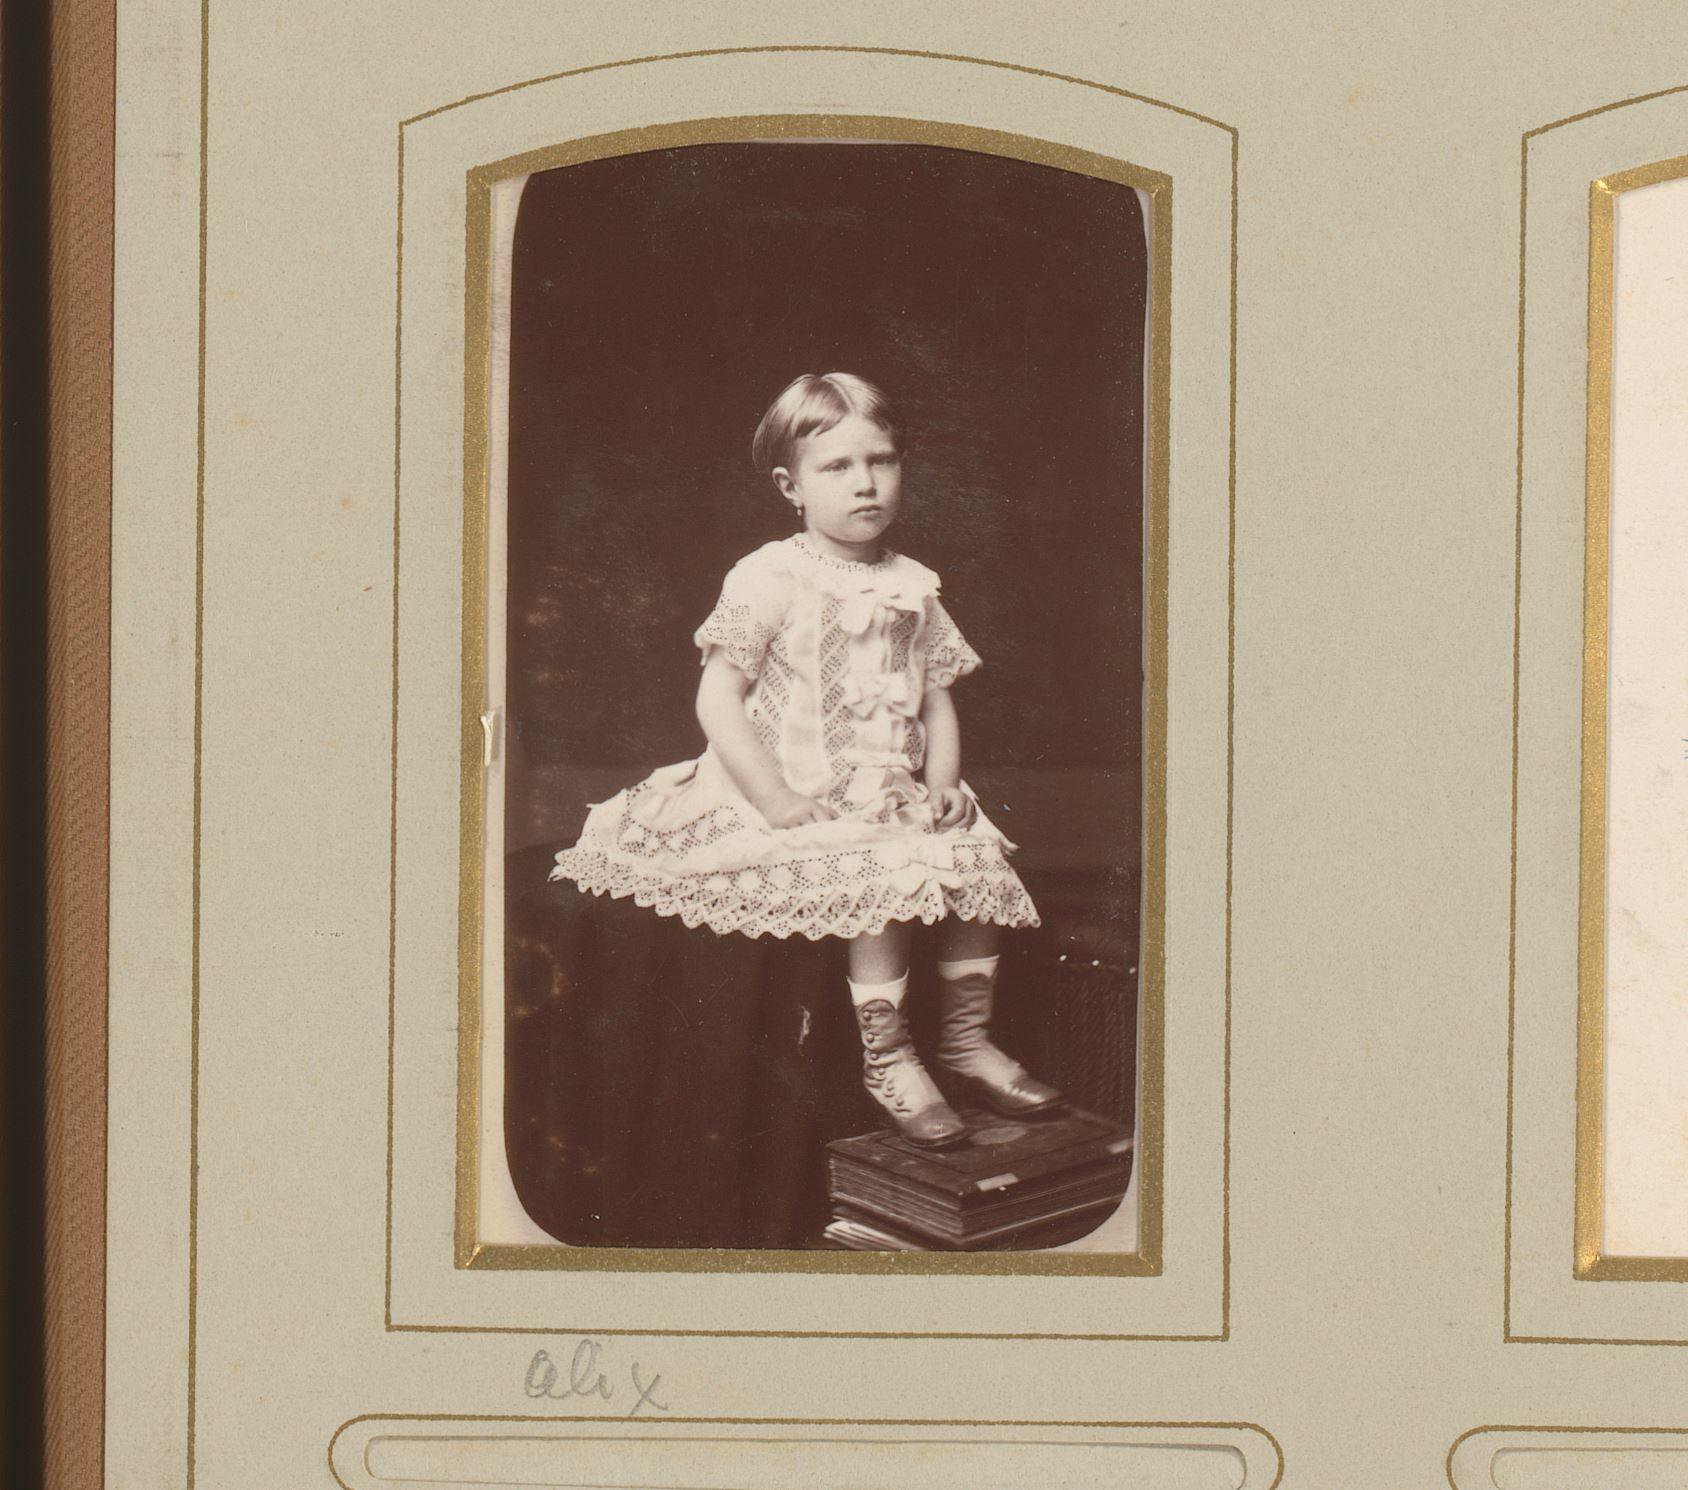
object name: semi enamel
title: Portret van een meisje, zittend op een tafel met haar voeten rustend op een boek, aangeduid als Alix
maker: jean b. van hoeter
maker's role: fotograaf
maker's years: 1840-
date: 1881-1888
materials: cardboard, celluloid, photographic support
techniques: albumen print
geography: brussels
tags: historical persons - bb - woman, table, book, toddler (female)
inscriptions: inscription: ‘J. VAN HOETER/ PHOTOGRAPHE/ Chaussee de Gand, 54/ coin de la Rue Ranfort/ Entrée par la porte cochère/ à MOLENBEEK-BRUXELLES’, name: ‘Alix’